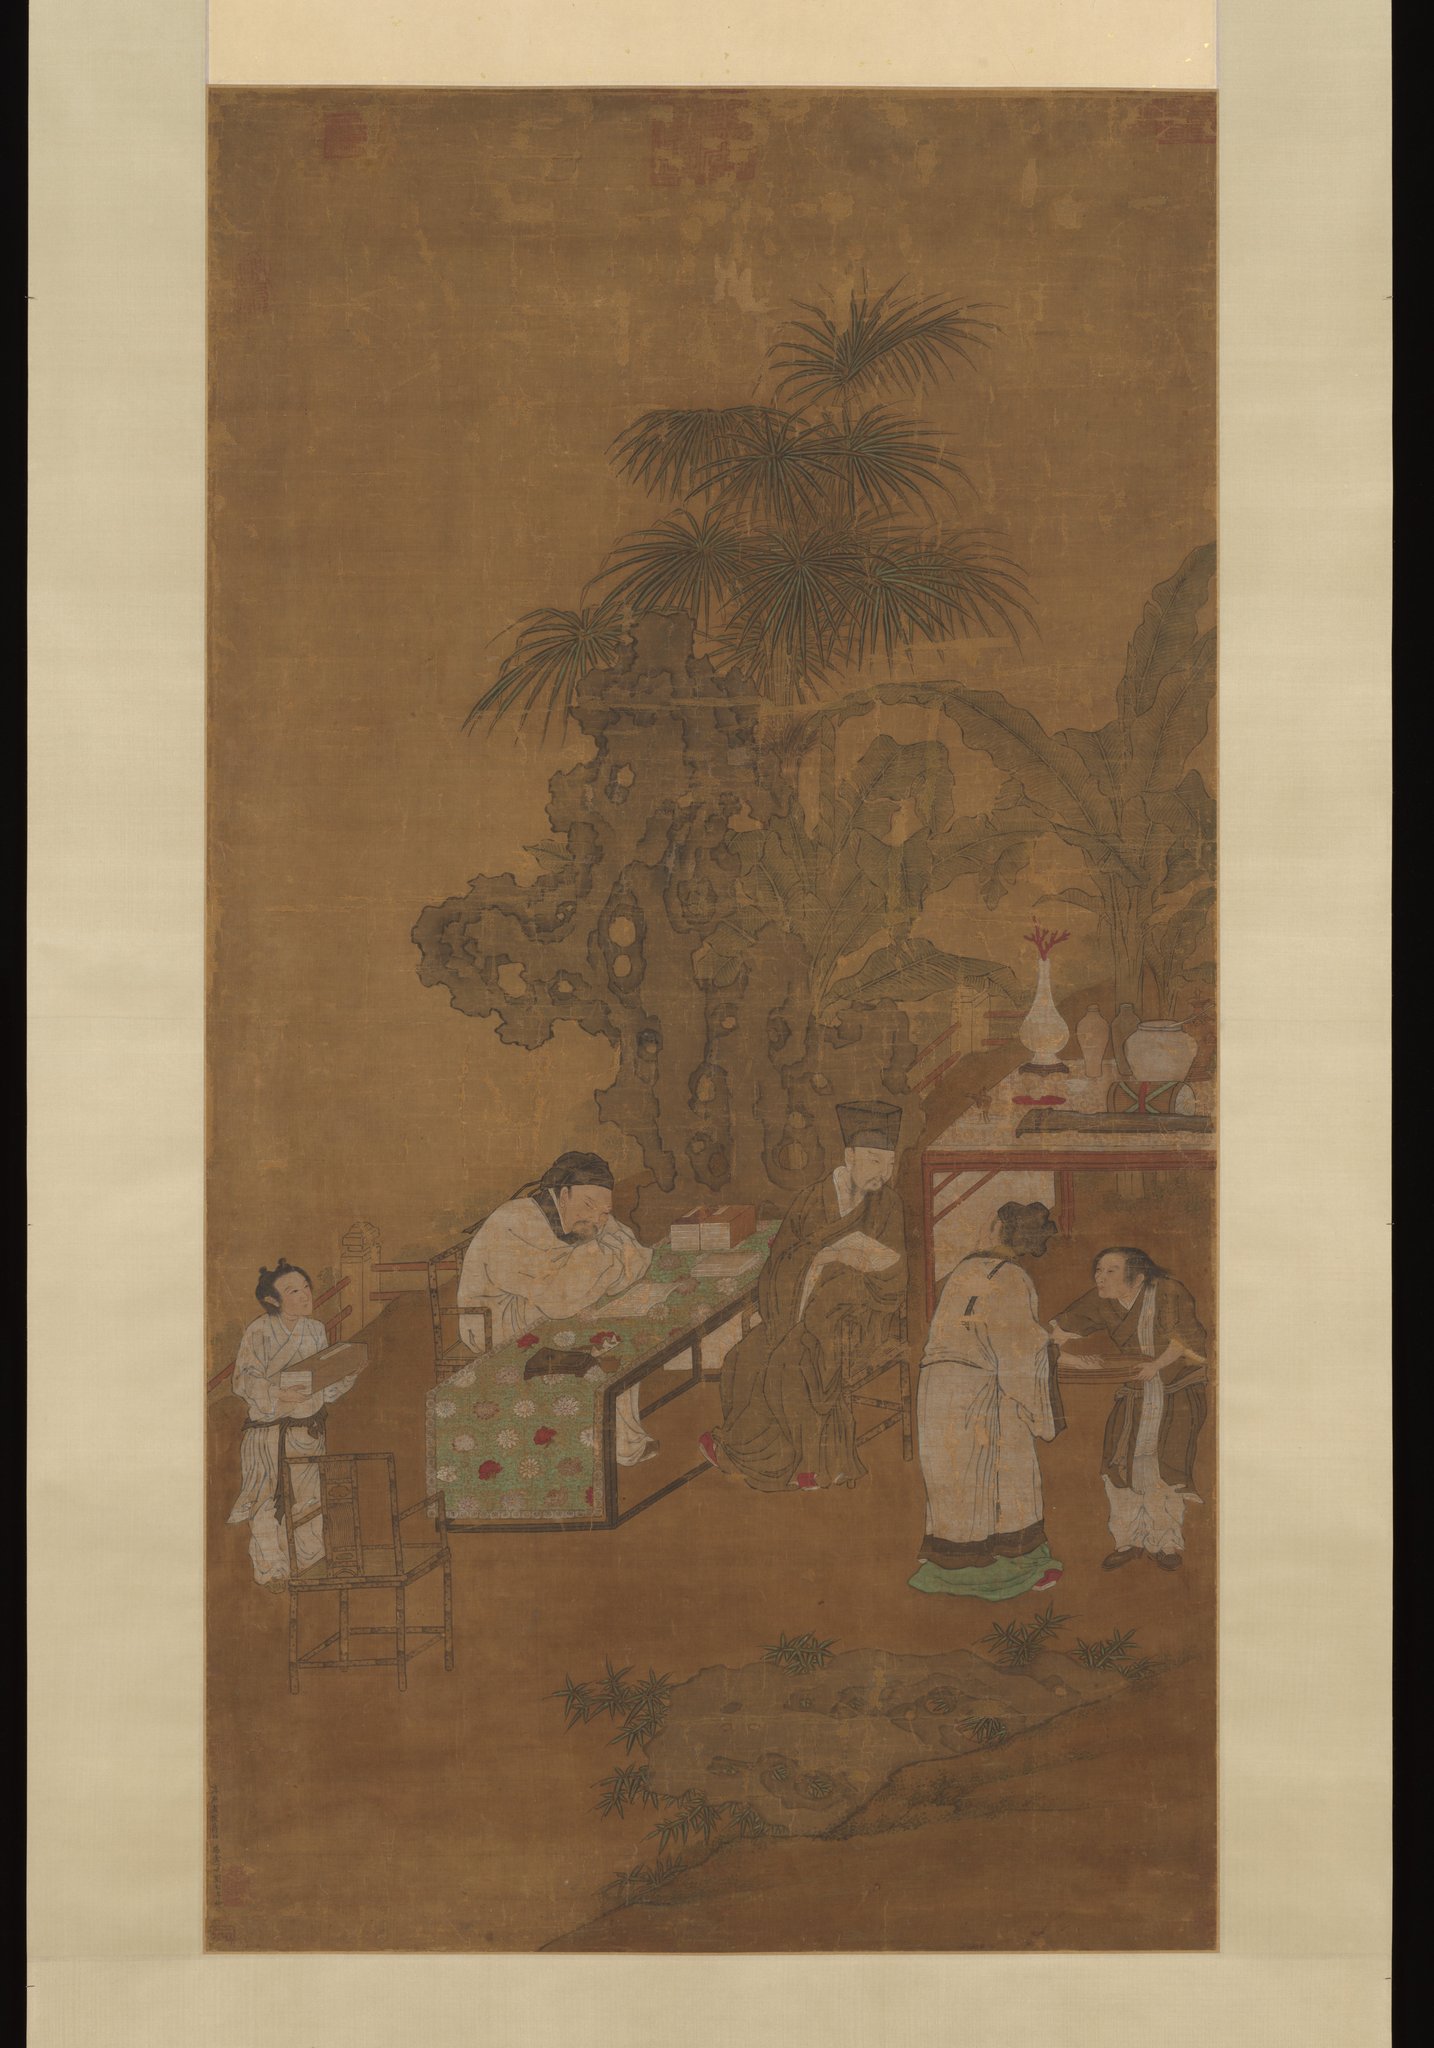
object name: hanging scroll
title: Elegant gathering in a garden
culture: chinese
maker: unidentified artist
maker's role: artist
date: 1401-1600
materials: ink, silk